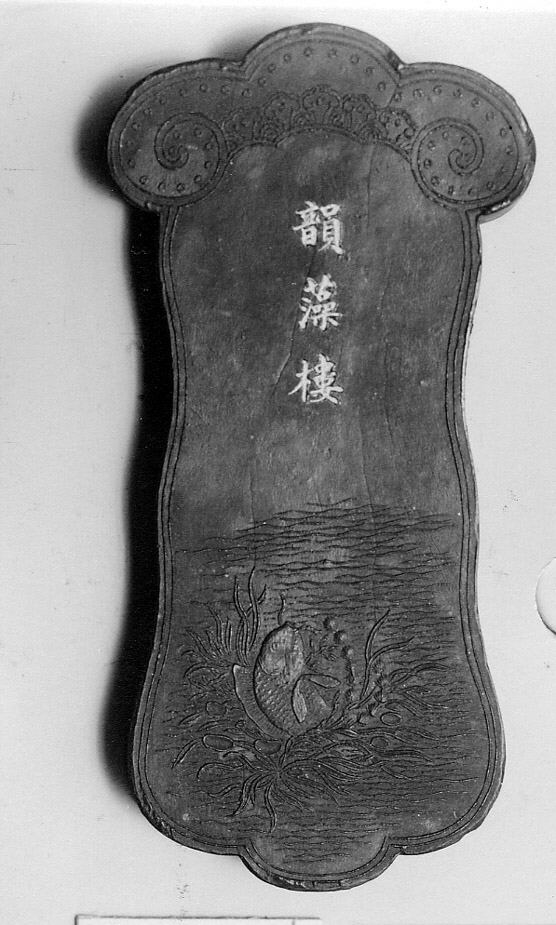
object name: ink tablet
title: Elegant Compositions Tower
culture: chinese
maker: jian guzhai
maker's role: artist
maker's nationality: chinese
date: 1867-1933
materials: ink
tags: fish